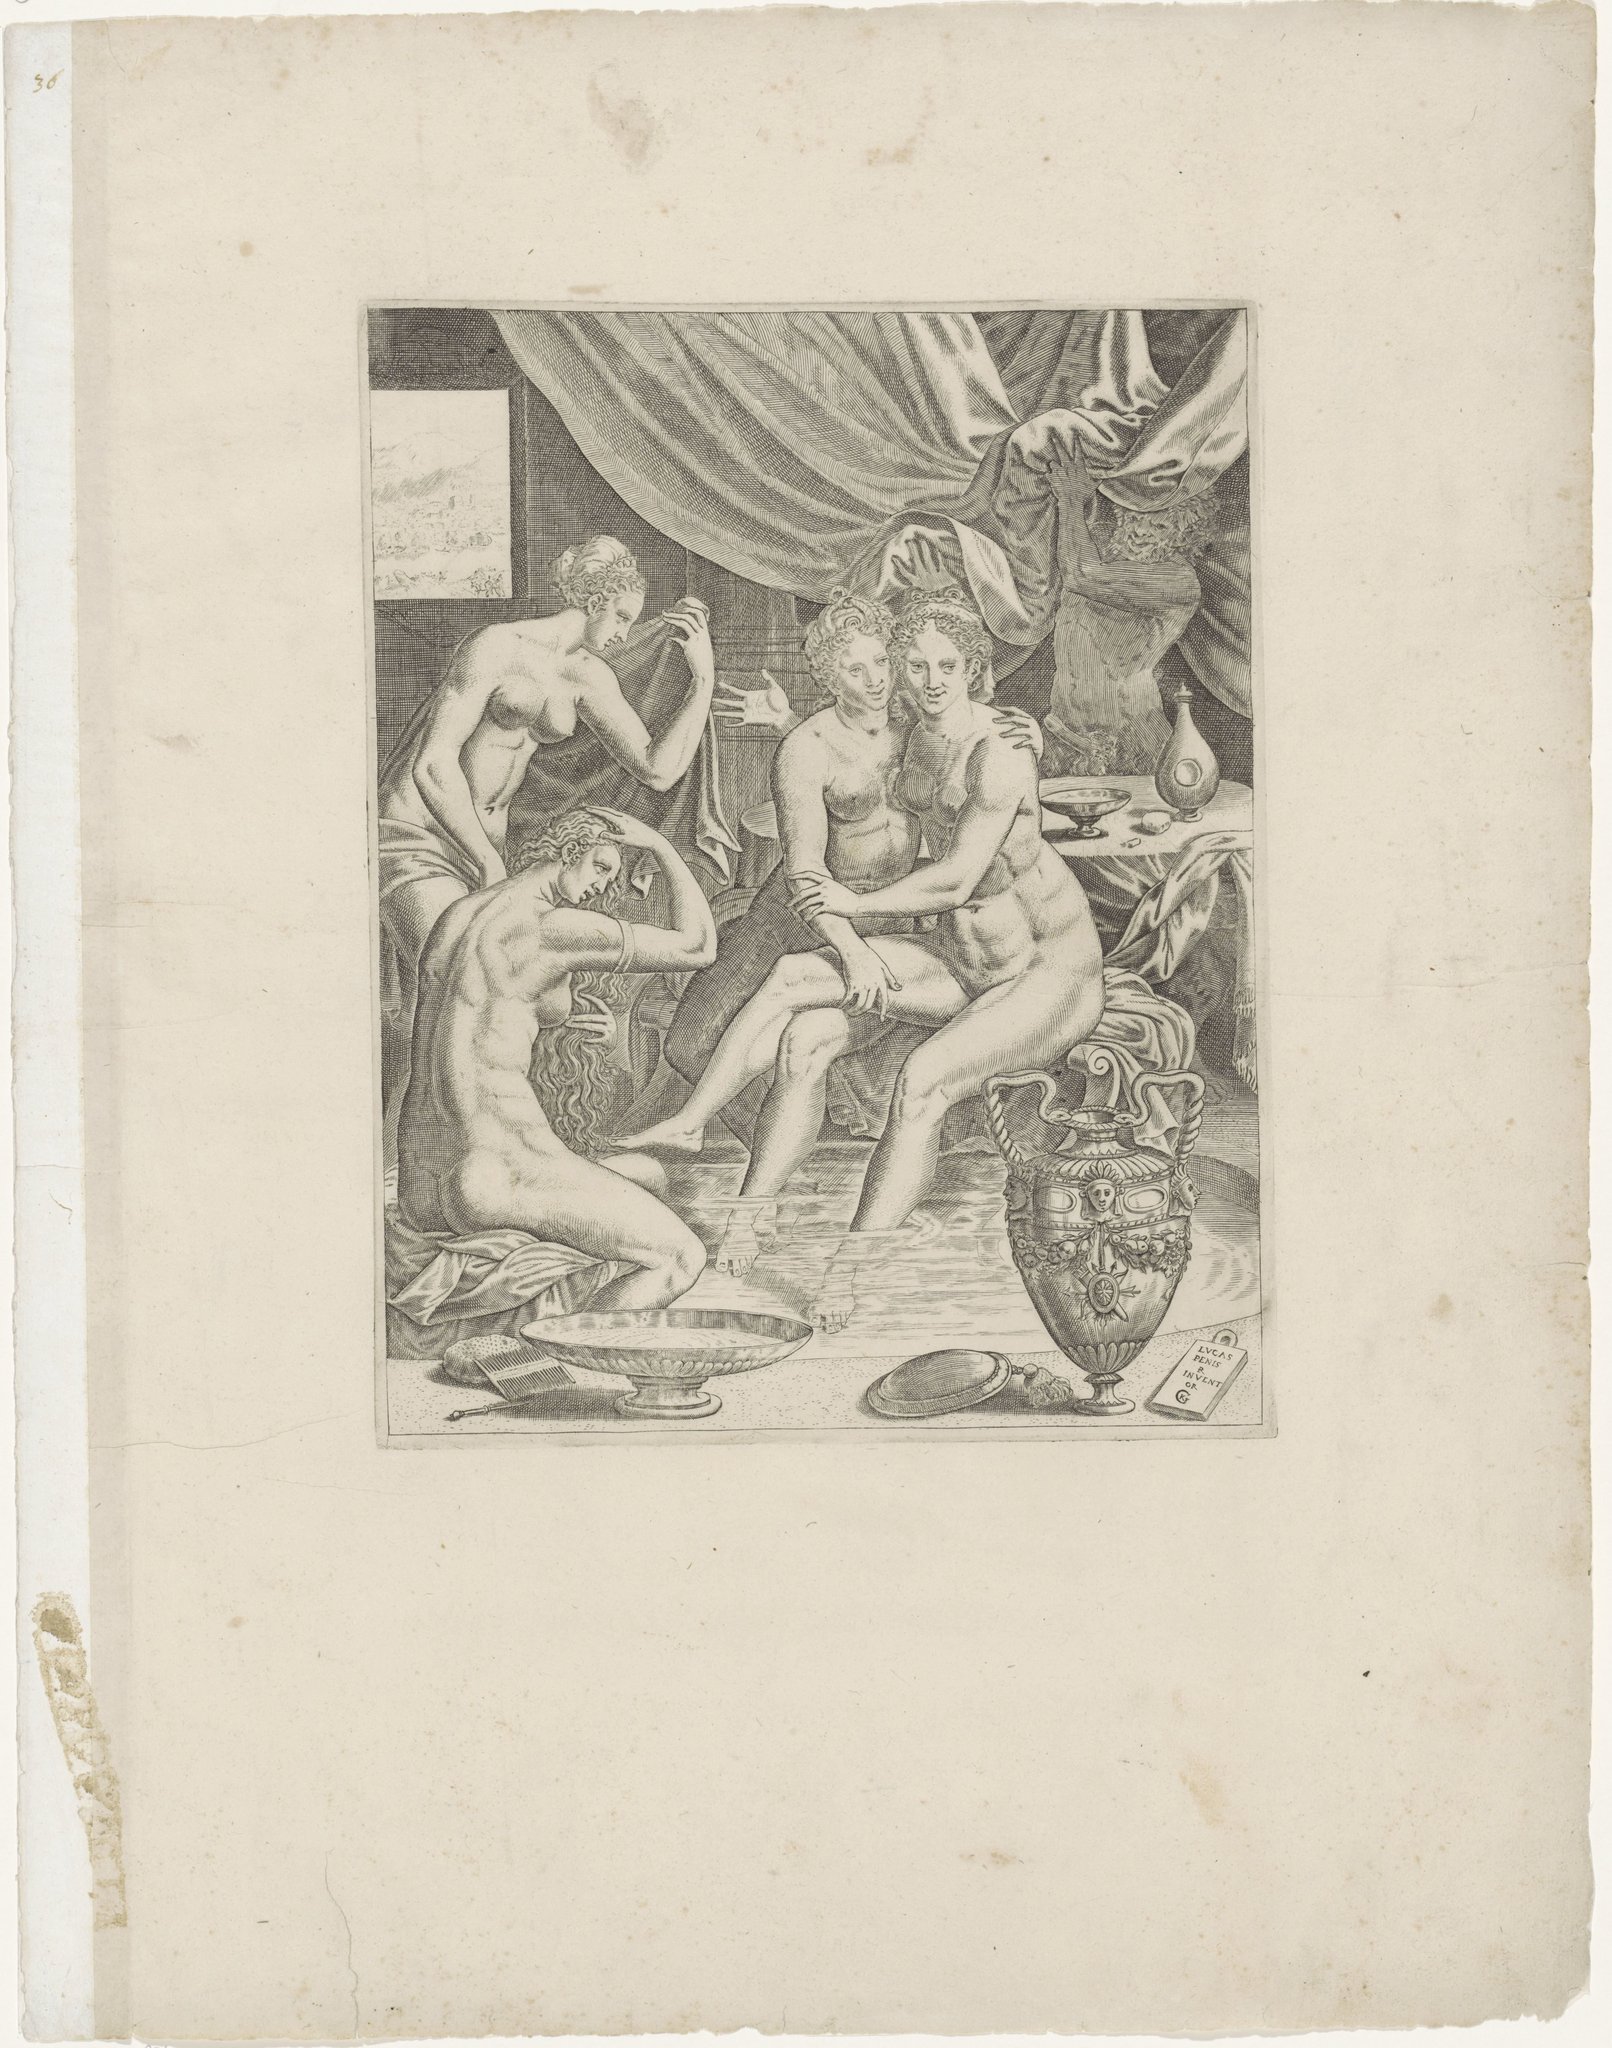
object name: album leaf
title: Four Women Bathing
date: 1550-1570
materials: paper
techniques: engraving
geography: italy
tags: bathing (movement in water) - aa - female human figure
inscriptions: number: ‘30’, collector's mark: Lugt 2228, collector's mark: Lugt 2760, watermark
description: In arranging his album, Zobel looked for witty combinations and visual jokes. For instance, the prints on this wall (from the section devoted to mythology and allegory) all have a foreground filled with water. The bodies of water assume various forms. Here it is a bath for women, with four elegant nude ladies being spied upon by a lecherous satyr hidden behind a curtain.